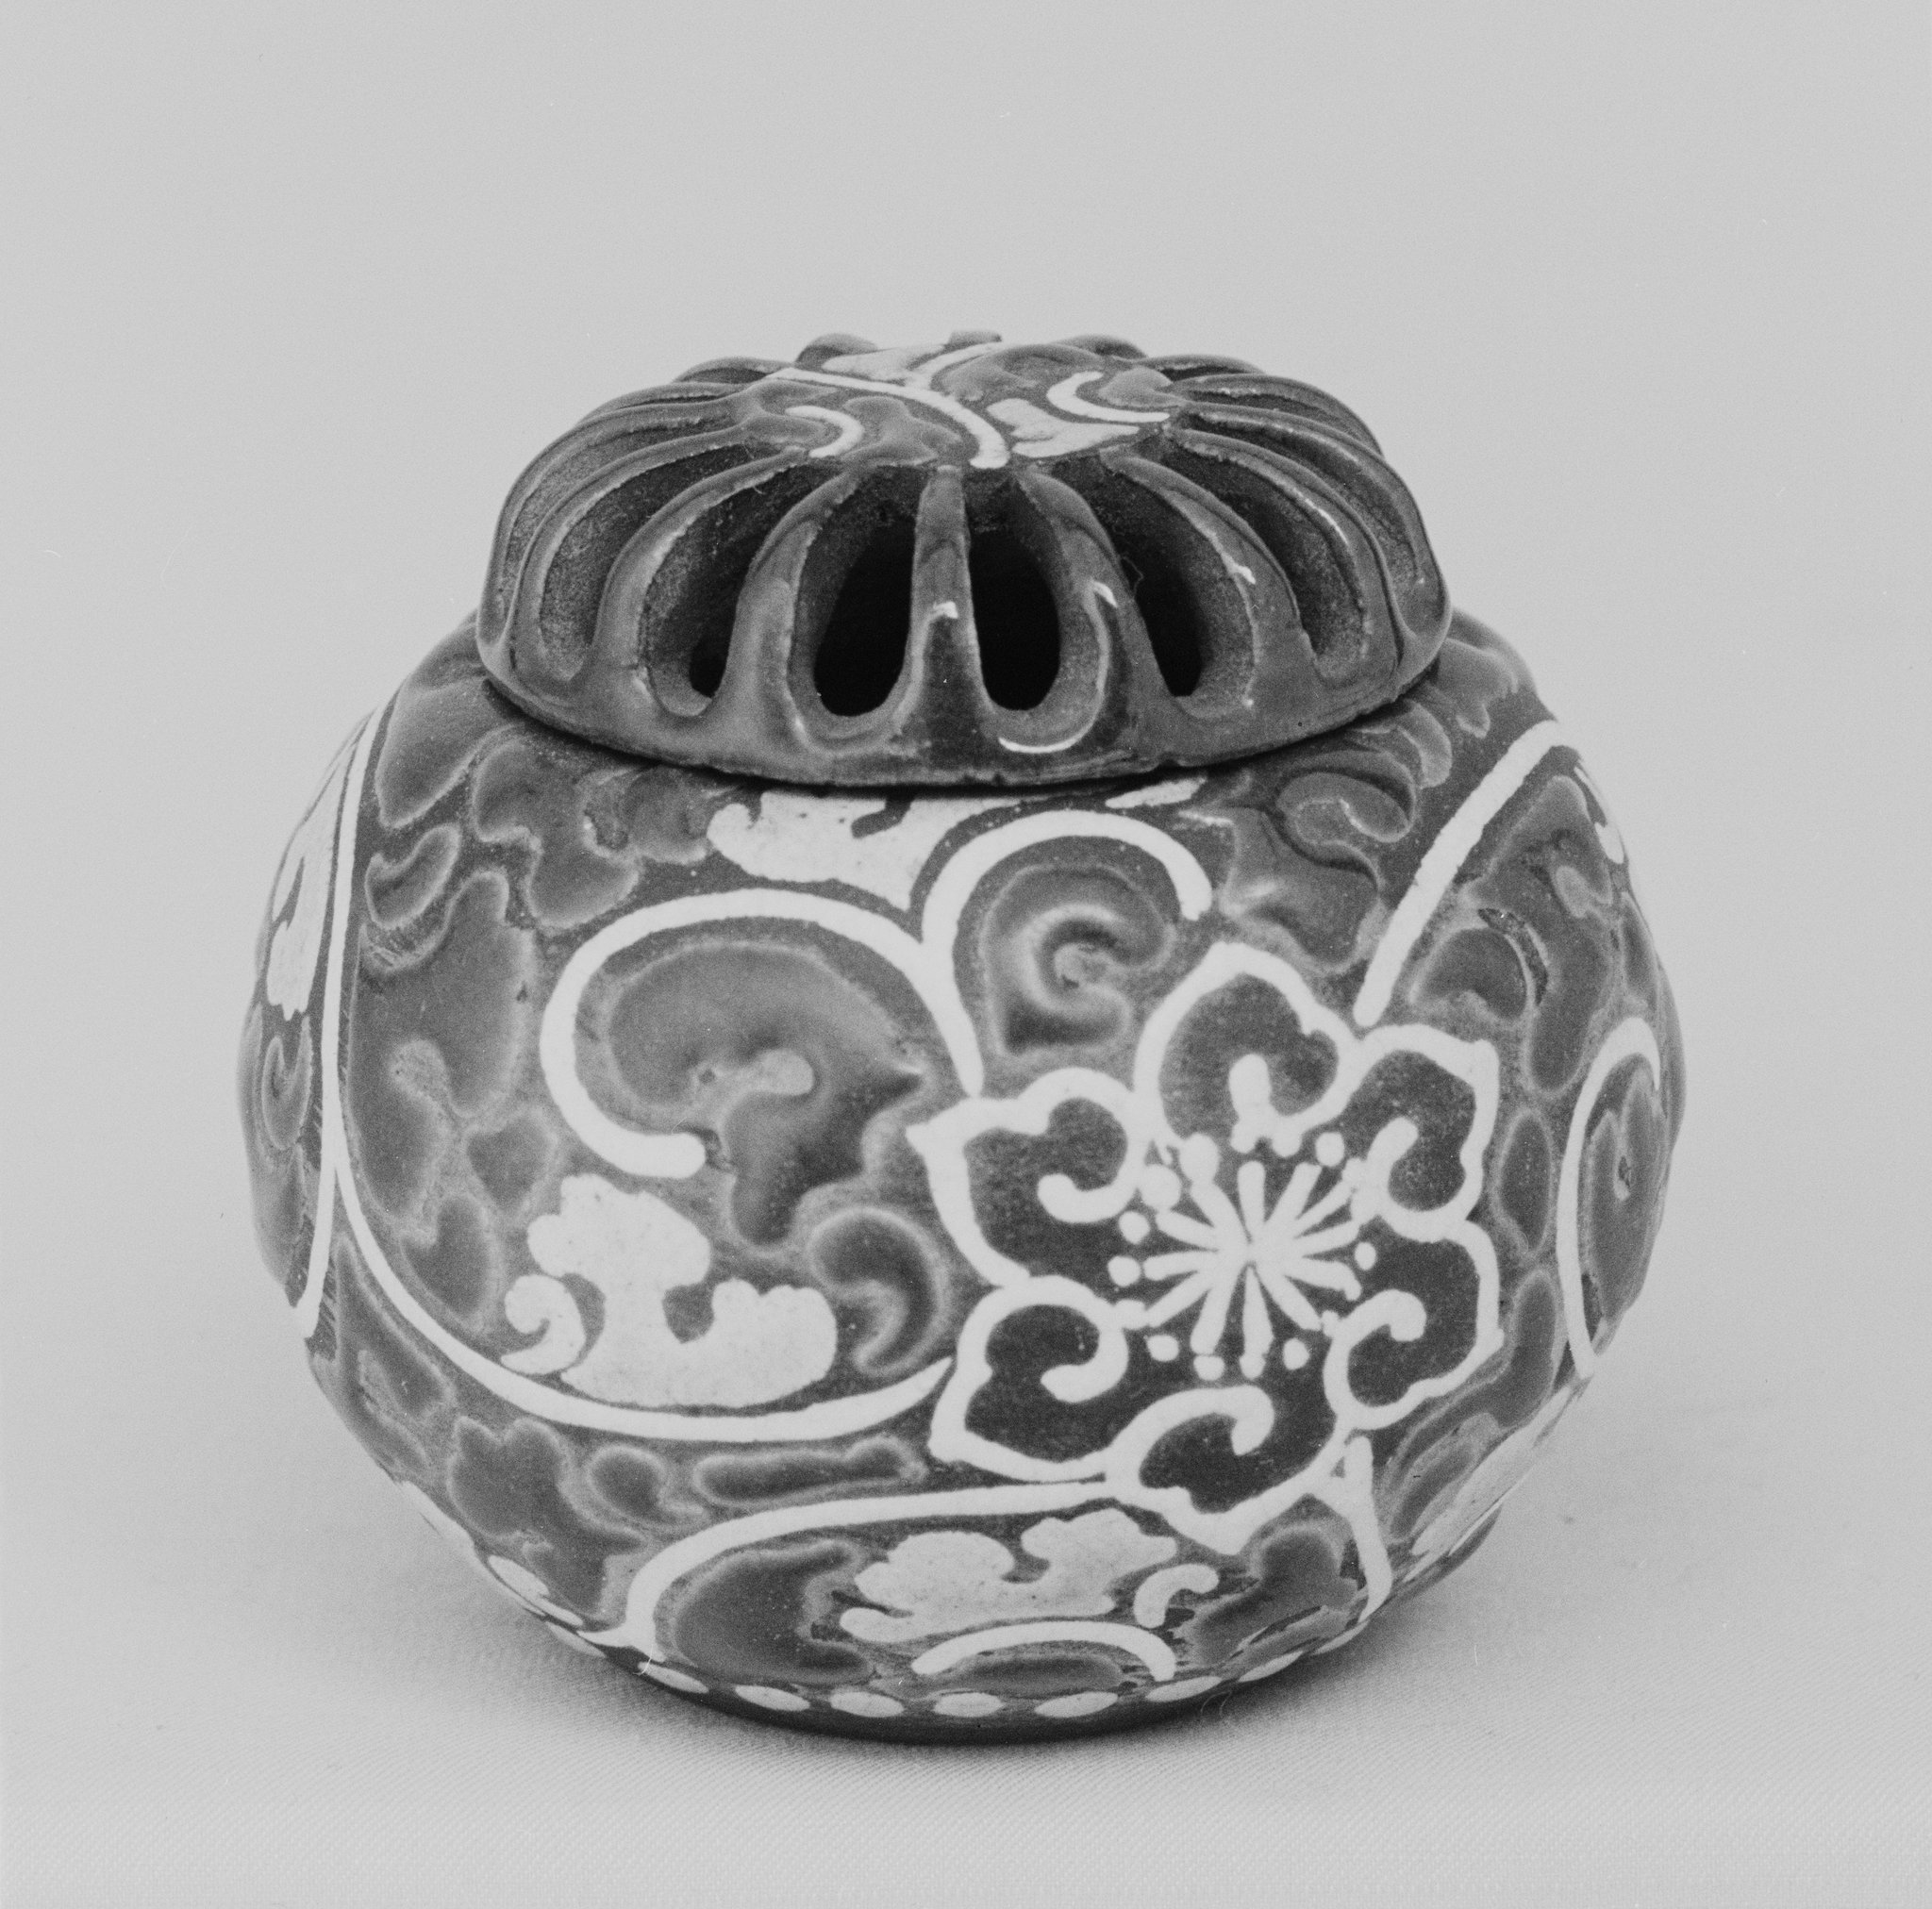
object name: incense burner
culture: japanese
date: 1801-1900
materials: clay, enamel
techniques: polychrome